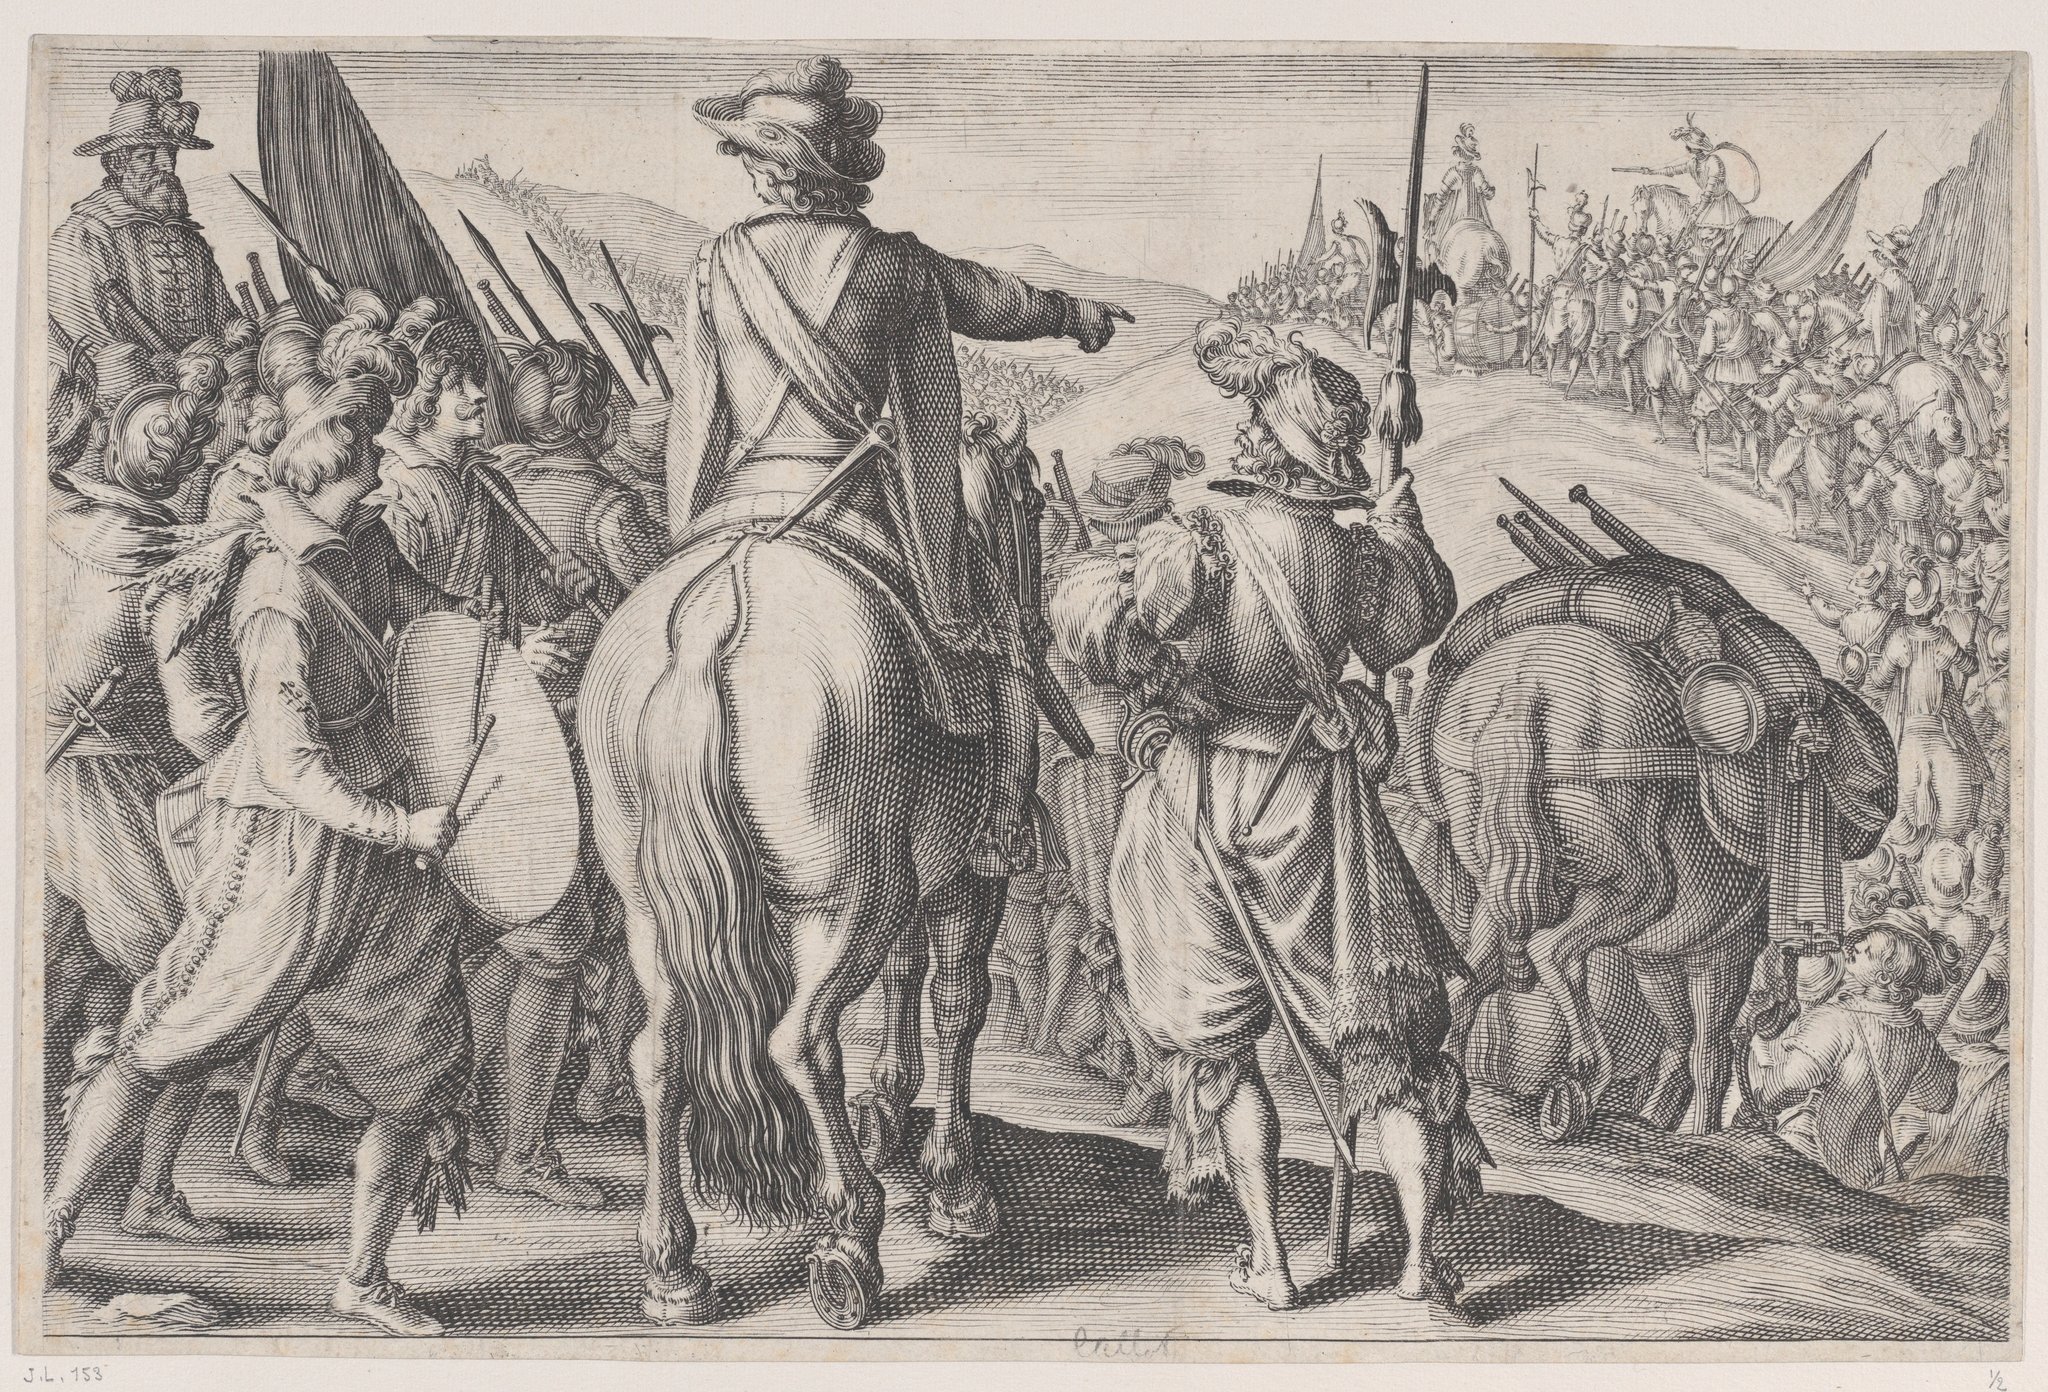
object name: print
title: Les Troupes en Marche (The Marching Troops), from "La Vie de Ferdinand Ier de Médicis série appelée aussi Les Batailles des Médicis" (The Life of Ferdinand I de'Medici also called The Medici Battles)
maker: jacques callot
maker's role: artist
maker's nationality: french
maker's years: 1592-1635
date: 1614-1620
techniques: engraving